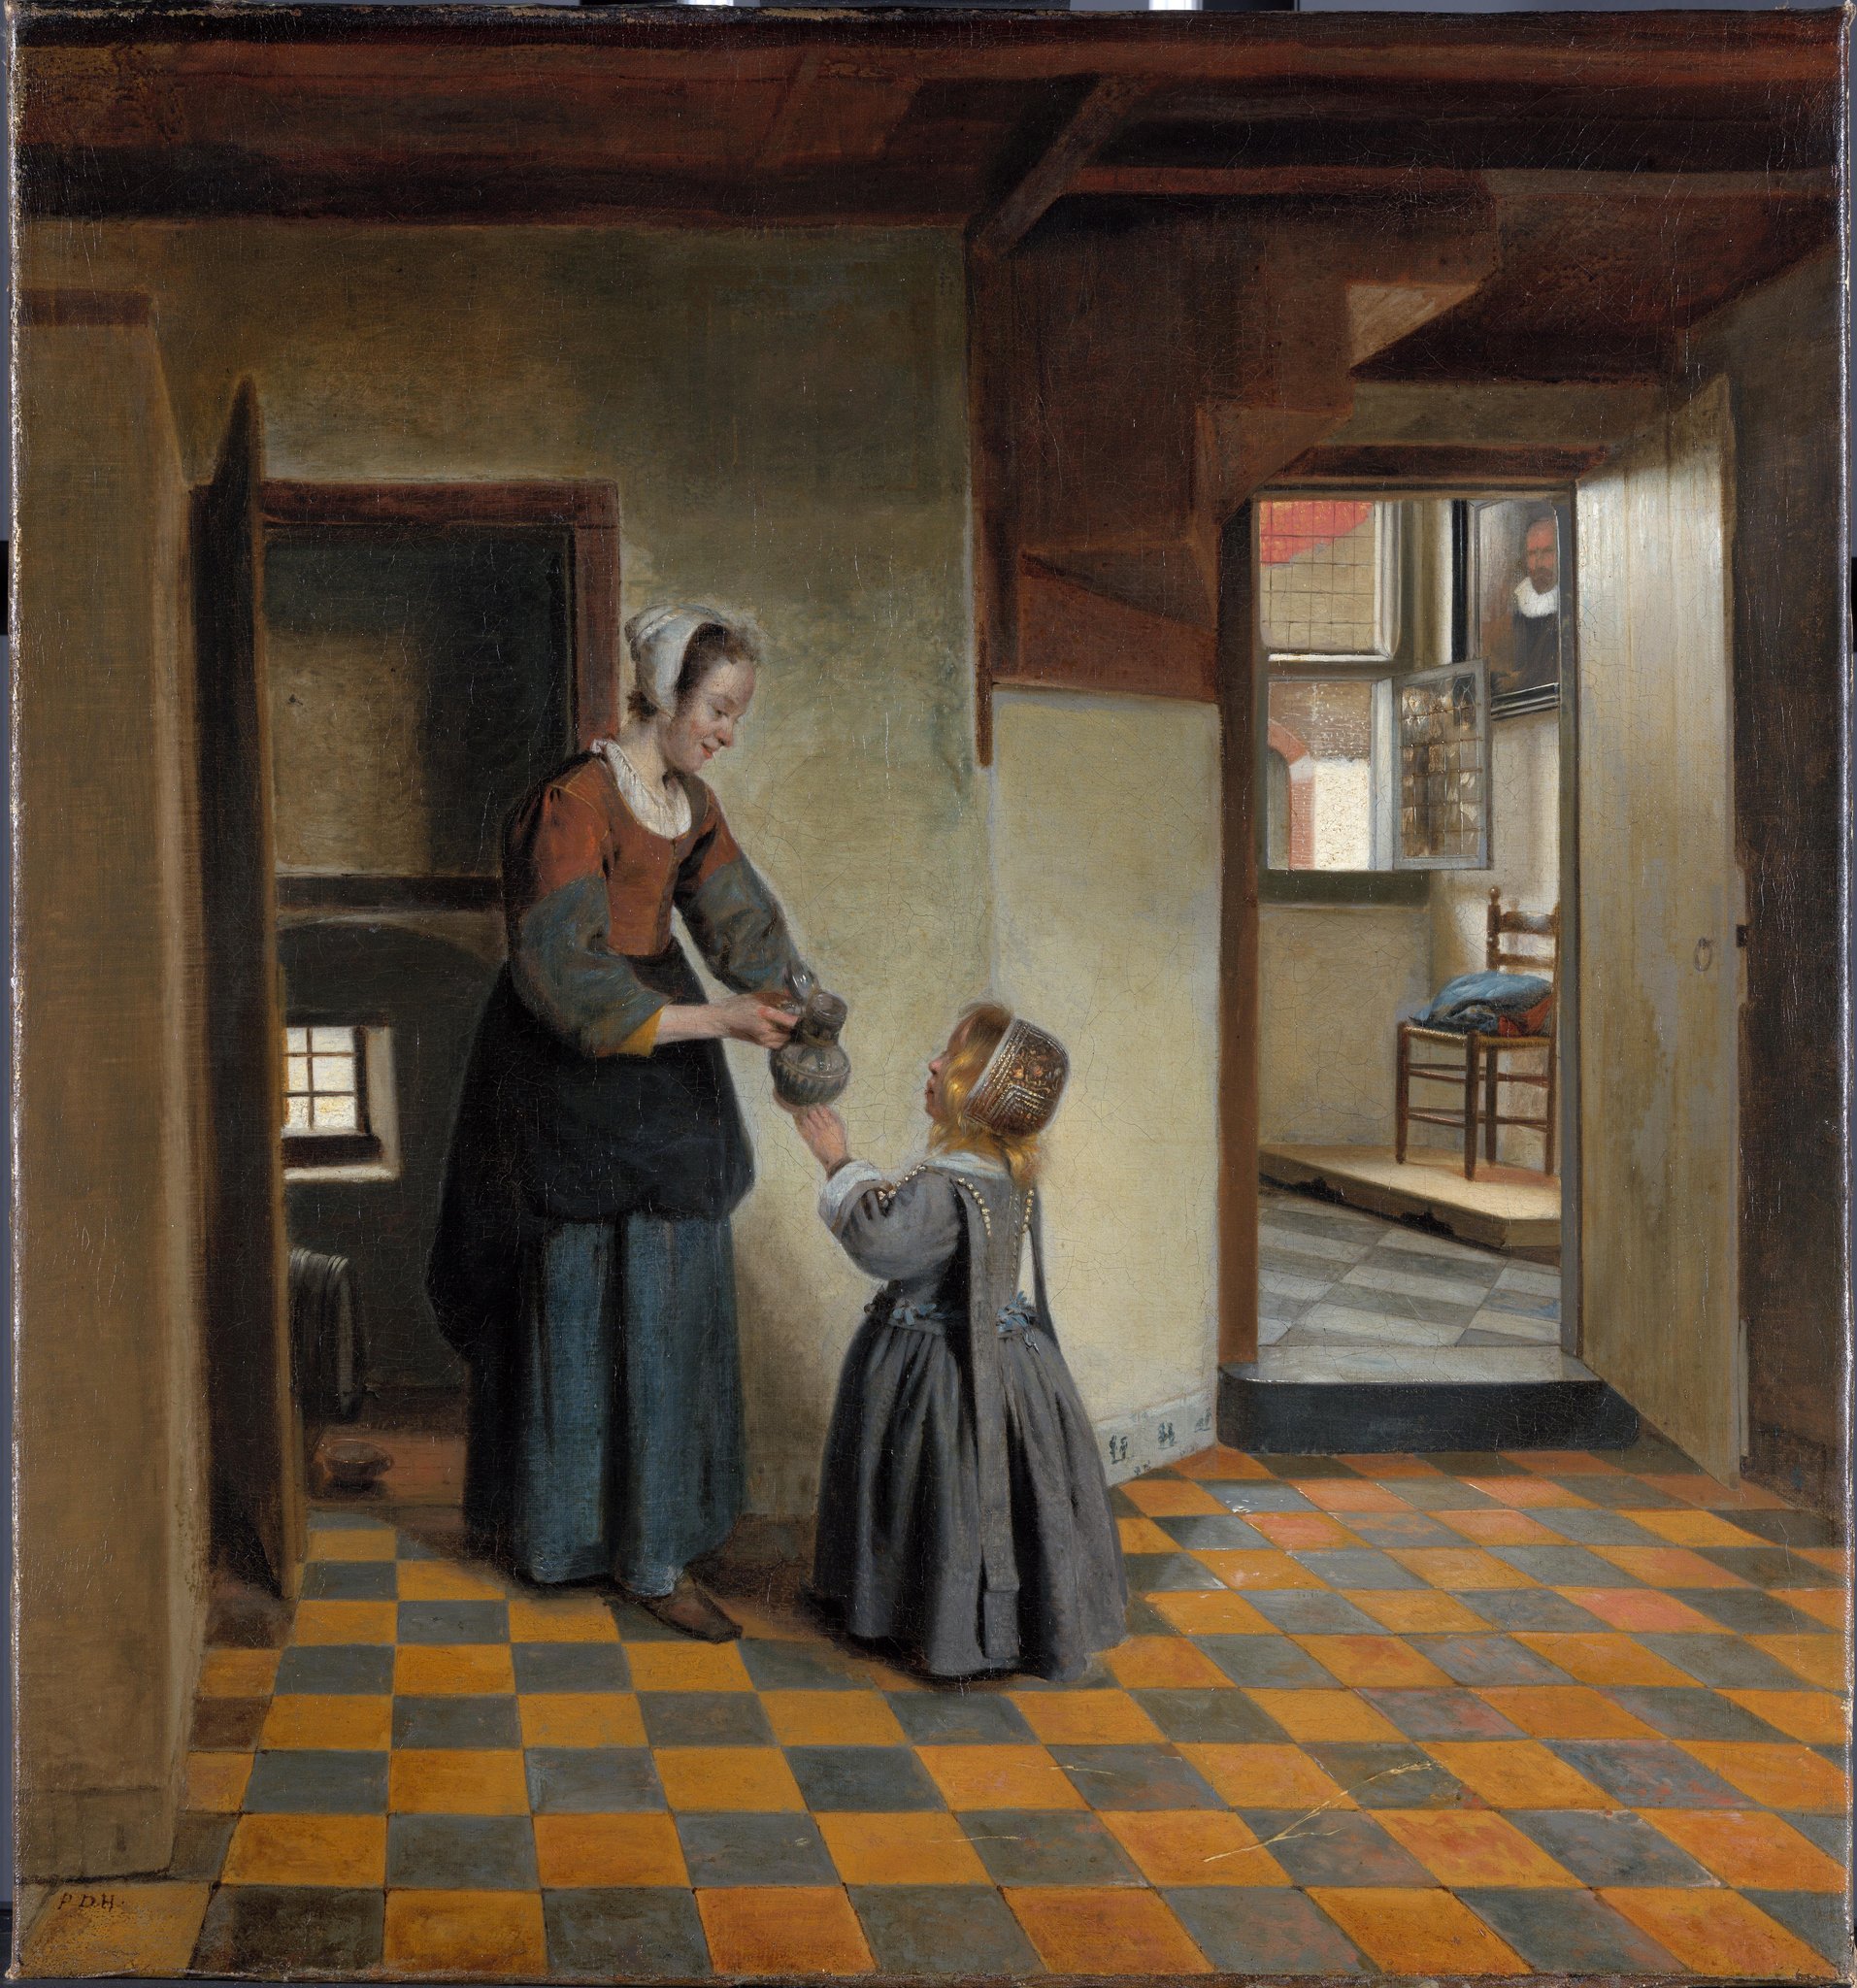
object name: painting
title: Woman with a Child in a Pantry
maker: pieter de hooch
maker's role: draughtsman, painter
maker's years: 1629-1679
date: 1656-1660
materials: canvas, oil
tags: girl (child between toddler and youth), interior of the house, container of metal: bucket, can, canister, drum, tin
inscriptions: signature: ‘P.D.H.’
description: A maidservant shows a little boy the contents of her jug. At that time, all children wore dresses with walking reins to hold onto them while they learned to walk. De Hooch was renowned for his views through one space to another. He depicted two here: one to the cellar and another to the front room, where he painted the daylight streaming in pure white.